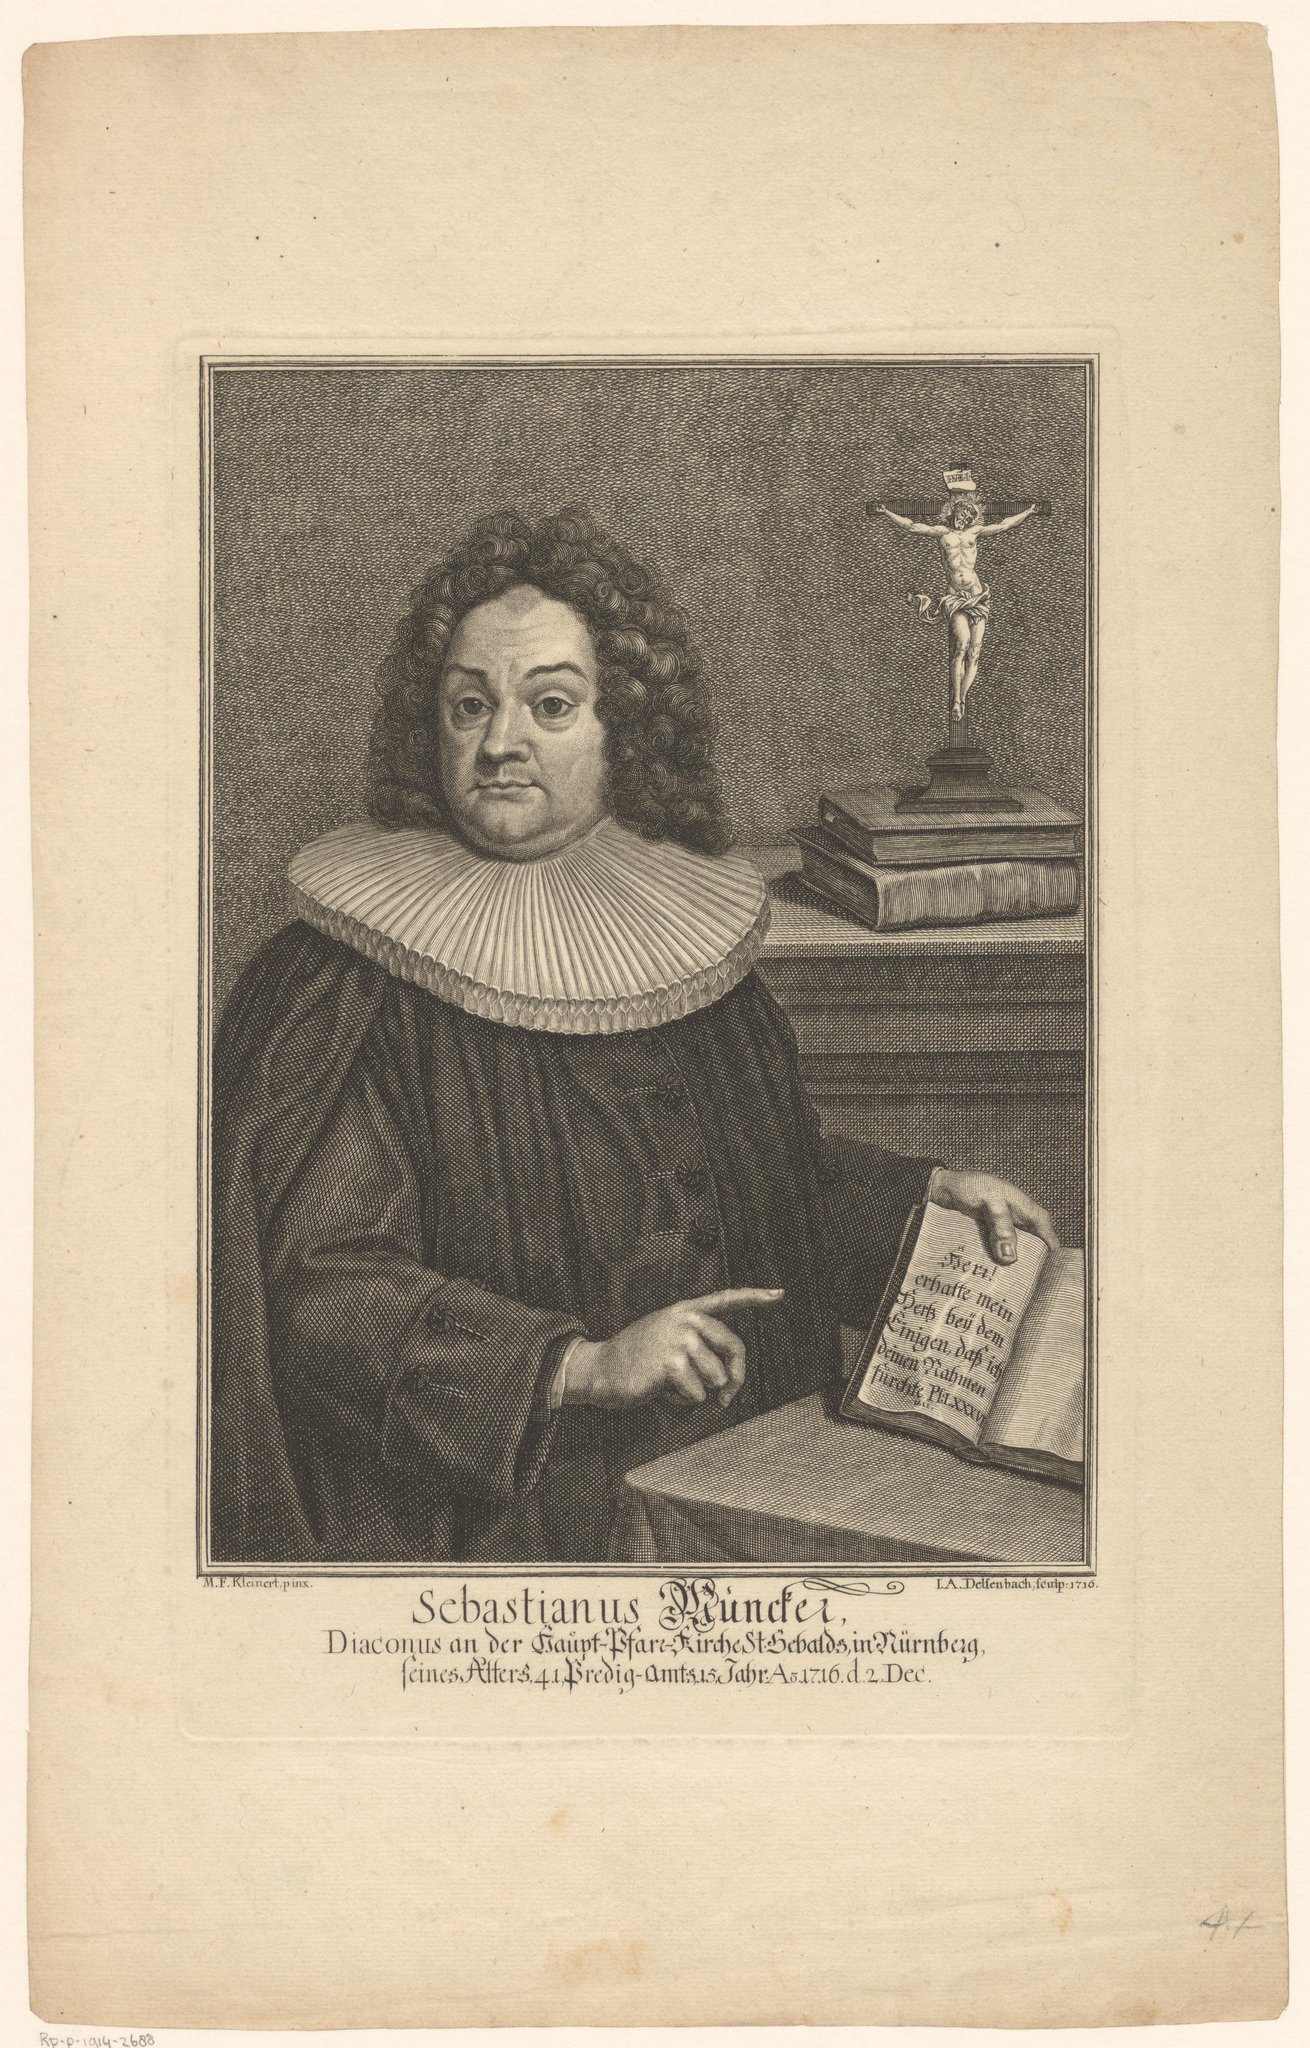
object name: print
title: Portret van Sebastian Munker op 41-jarige leeftijd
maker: johann adam delsenbach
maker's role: print maker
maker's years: 1687-1765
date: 1716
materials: paper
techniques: engraving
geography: nuremberg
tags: historical persons, book - mm - book open, cross with symbol of christ on it, e.g. lamb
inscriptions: collector's mark: Lugt 2228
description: De geportretteerde wijst naar een opengeslagen boek waarin psalm 86.7 is afgebeeld.